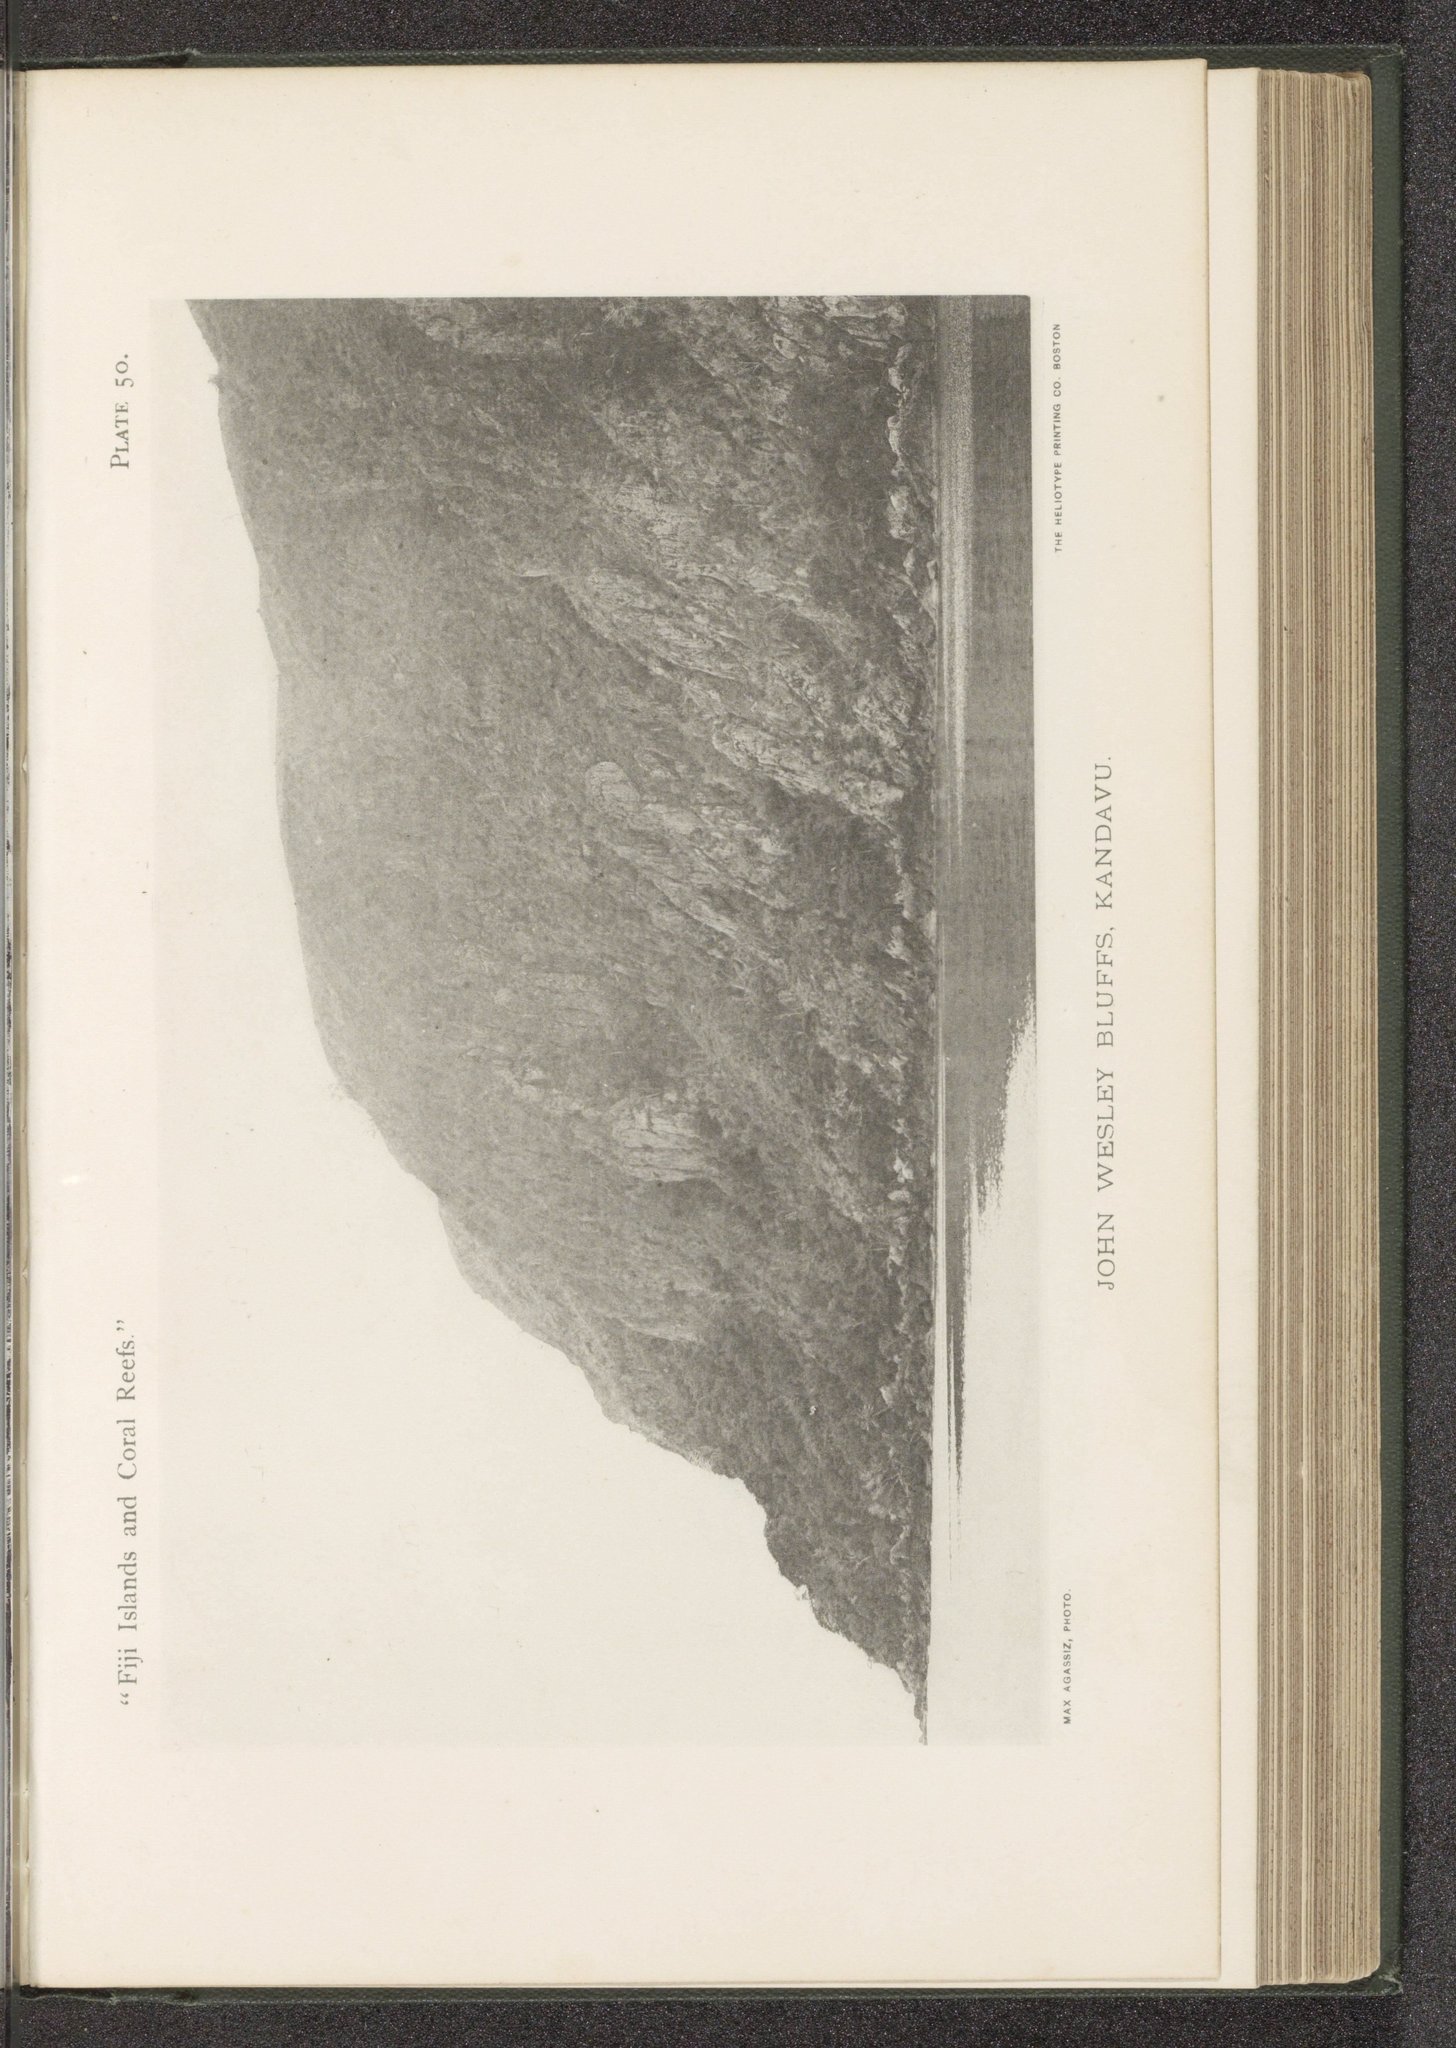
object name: page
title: Gezicht op de John Wesley kaap op Kadavu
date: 1885-1899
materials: paper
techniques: photograph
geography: boston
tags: island, cape (coast)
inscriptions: name: ‘The Heliotype Printing Co. Boston’, number: ‘Plate 50.’, name: ‘Max Agassiz, Photo’